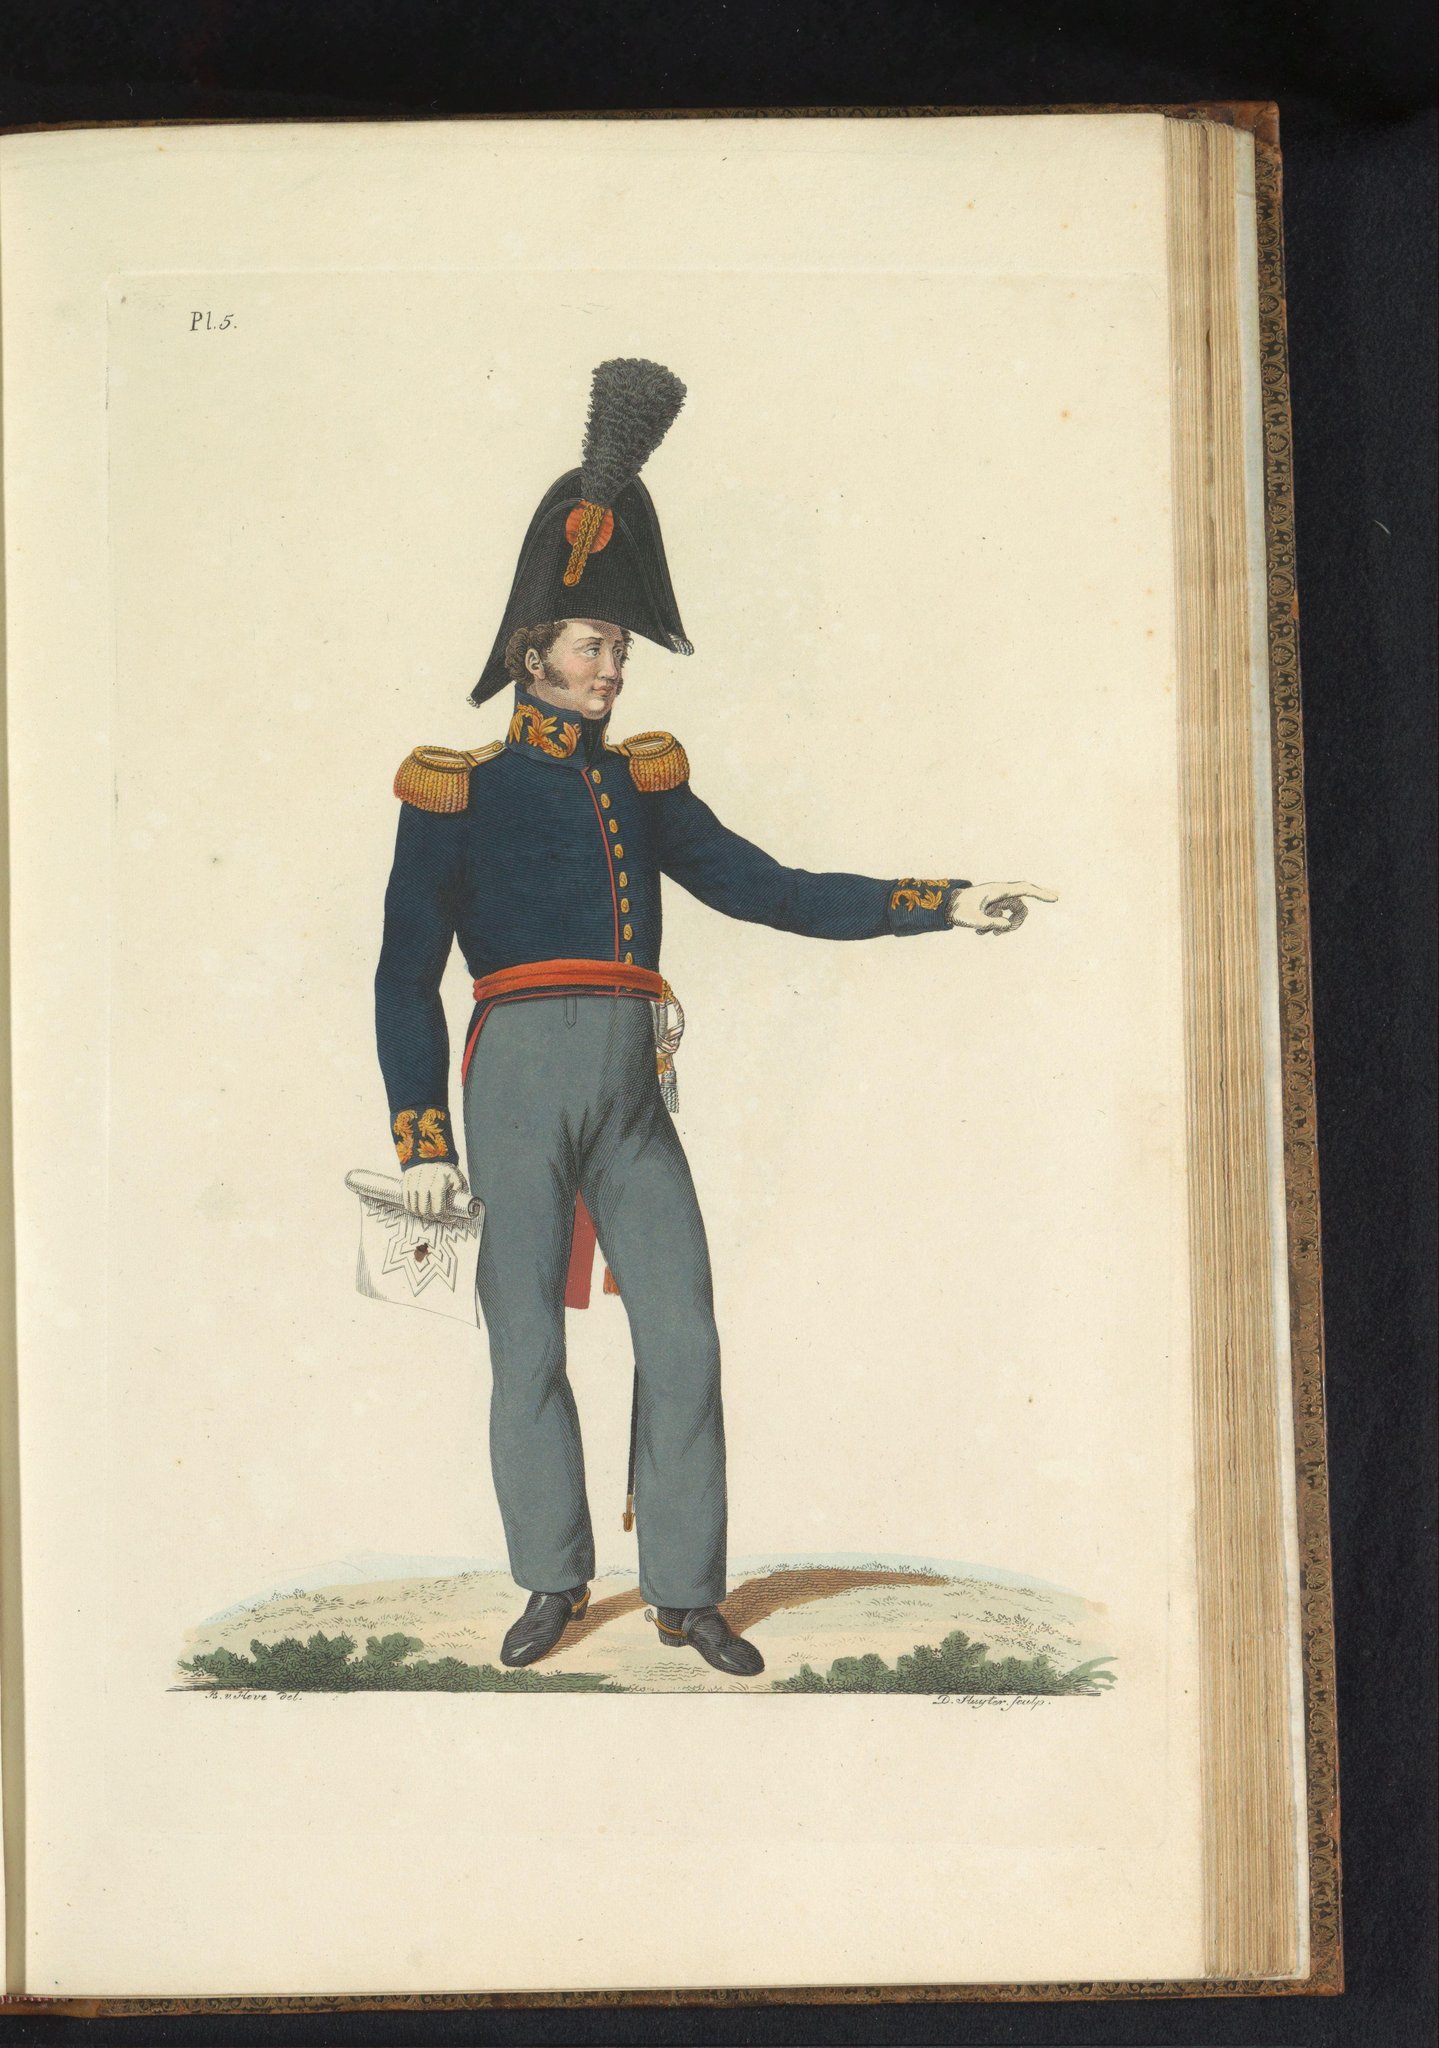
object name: print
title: Majoor van de Genie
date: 1823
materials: paper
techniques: engraving, etching, hand coloring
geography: netherlands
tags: (military) uniforms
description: Een Nederlandse majoor van de genie. Plaat 5. Uniformvoorstelling in 'Beschrijving hoedanig de Koninklijke Nederlandsche troepen' van J.F. Teupken, 1823.